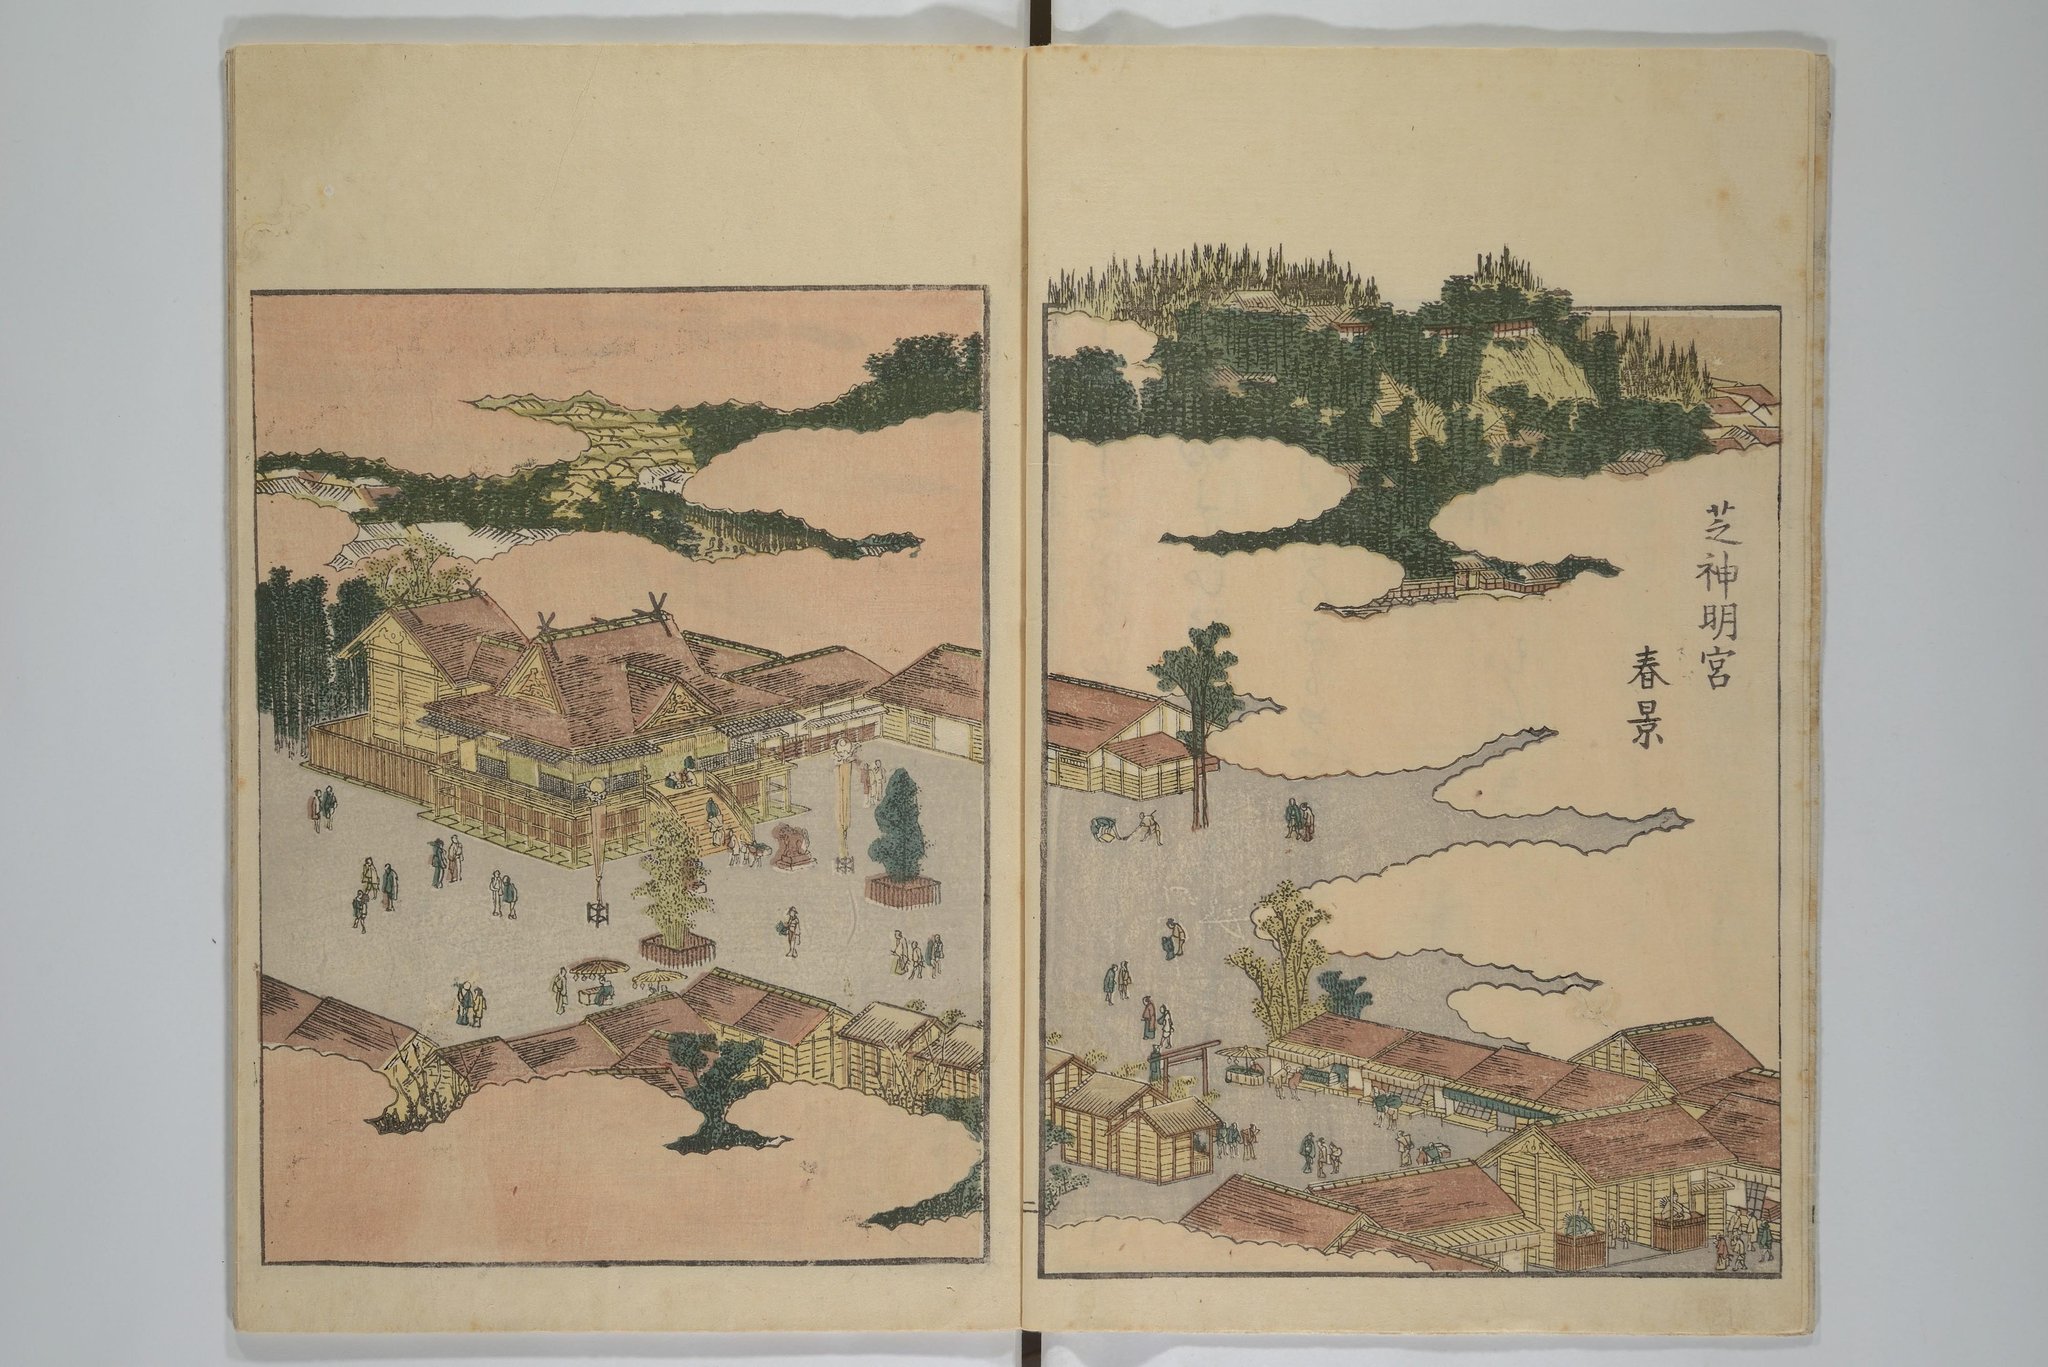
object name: illustrated book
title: Picture Book of the Pleasures of the East (Ehon azuma asobi) 画本東都遊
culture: japanese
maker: katsushika hokusai 葛飾北斎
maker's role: artist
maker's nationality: japanese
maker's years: 1760-1849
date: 1802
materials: ink, paper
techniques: woodblock print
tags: human figures,houses,landscapes